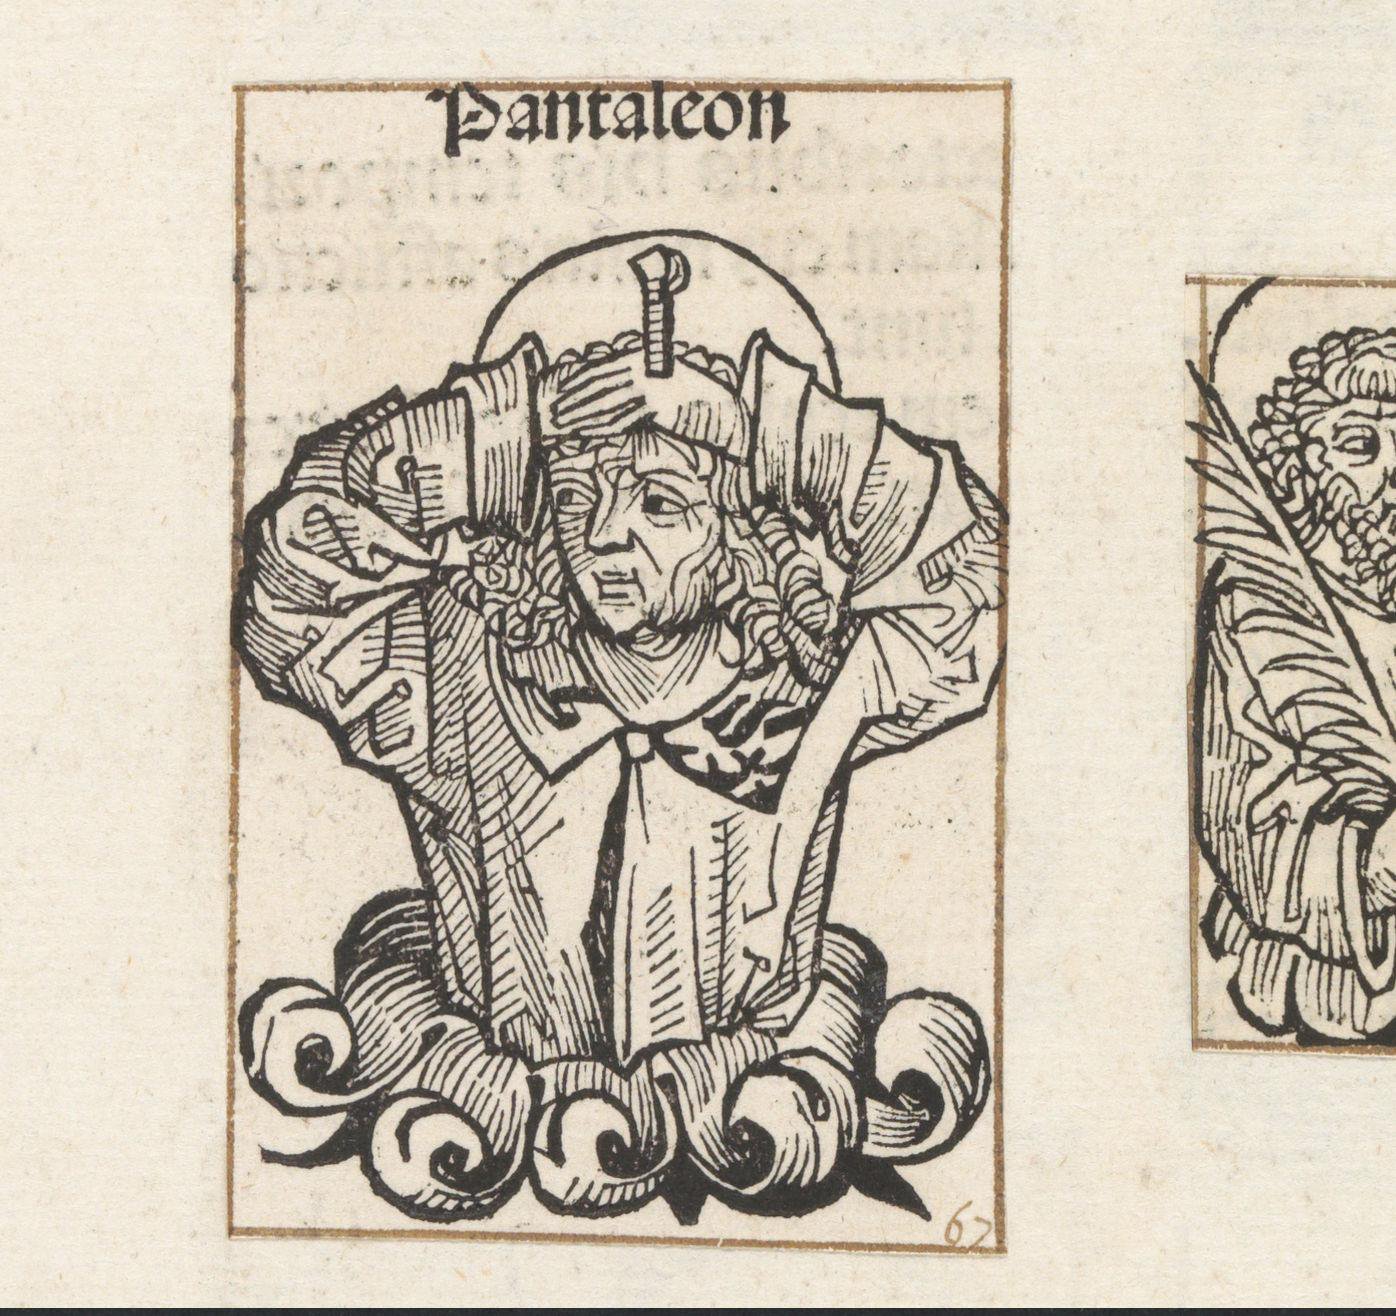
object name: album leaf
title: Pantaleon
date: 1493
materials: paper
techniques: letterpress printing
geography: nuremberg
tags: saints, martyr(s) (often with palm-branches)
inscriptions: inscription: ‘67’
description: De houtsnede wordt herhaaldelijk gebruikt als boekillustratie in de Liber Chronicarum (of Neurenbergkroniek) van Hartmann Schedel, verschenen in het Latijn en Duits in 1493. Zie de Latijnse uitgave, folio 125r.